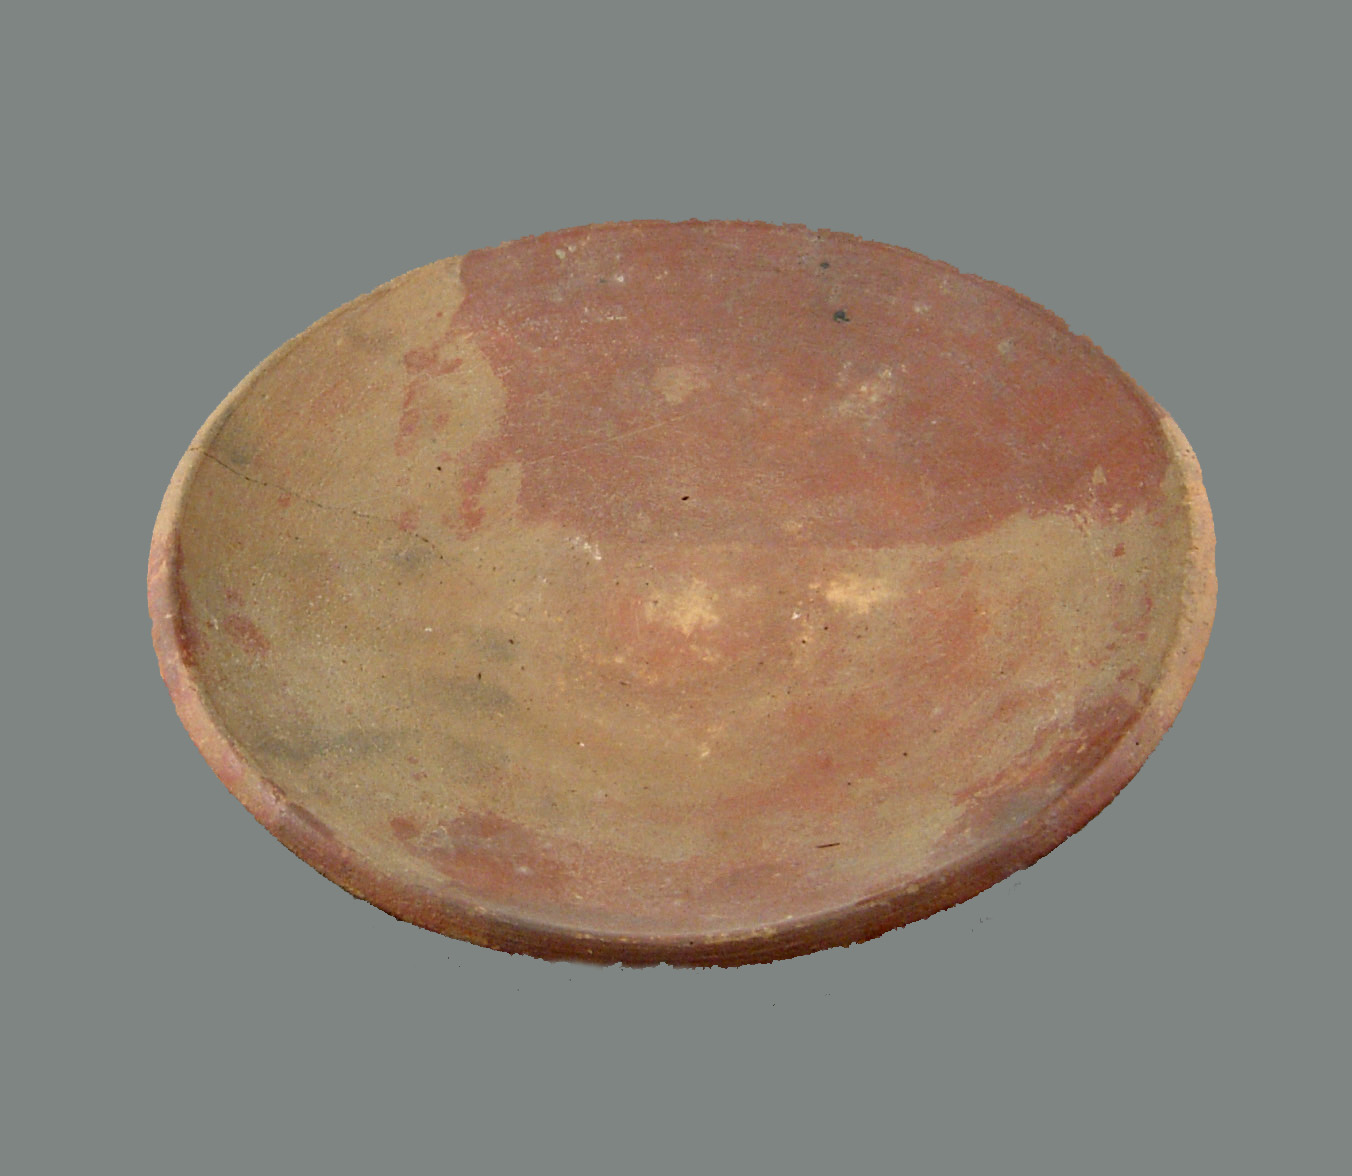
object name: dish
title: Dish from Tutankhamun's Embalming Cache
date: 1336-1327 BCE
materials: mineral, pottery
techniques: wash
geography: egypt